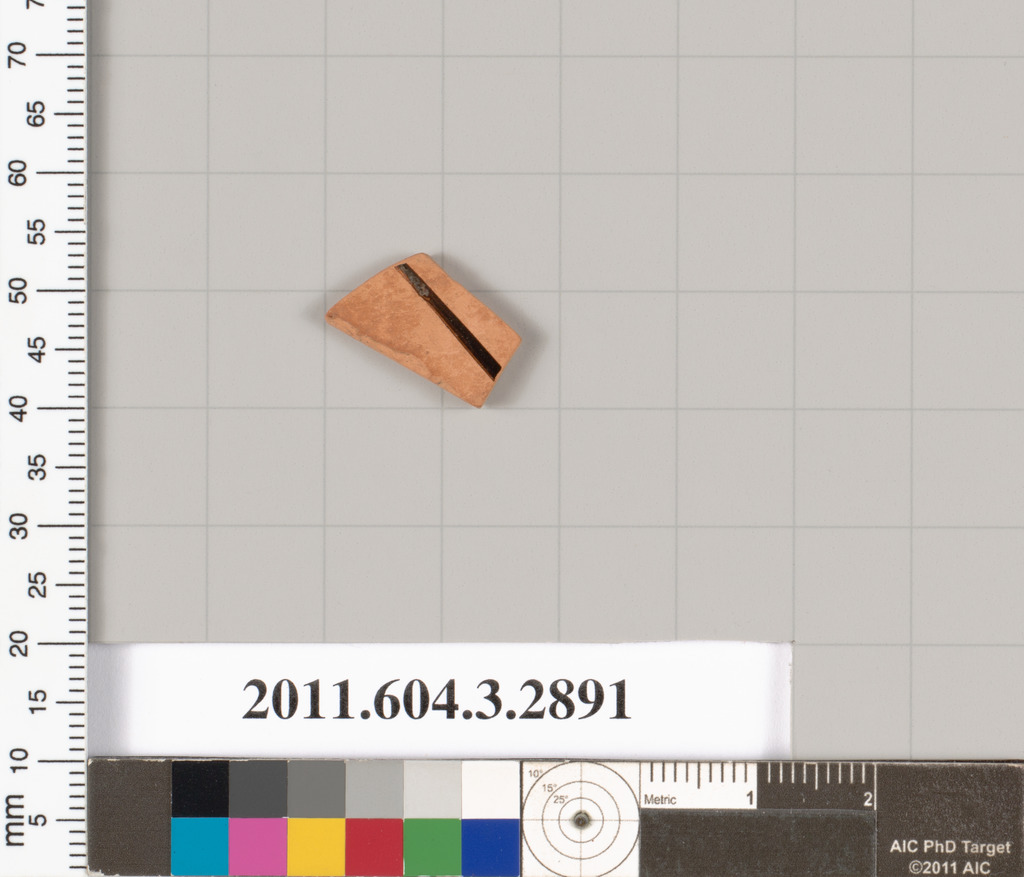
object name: kylix fragment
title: Terracotta fragment of a kylix: eye-cup (drinking cup)?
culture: greek, attic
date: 525-501 BCE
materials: terracotta